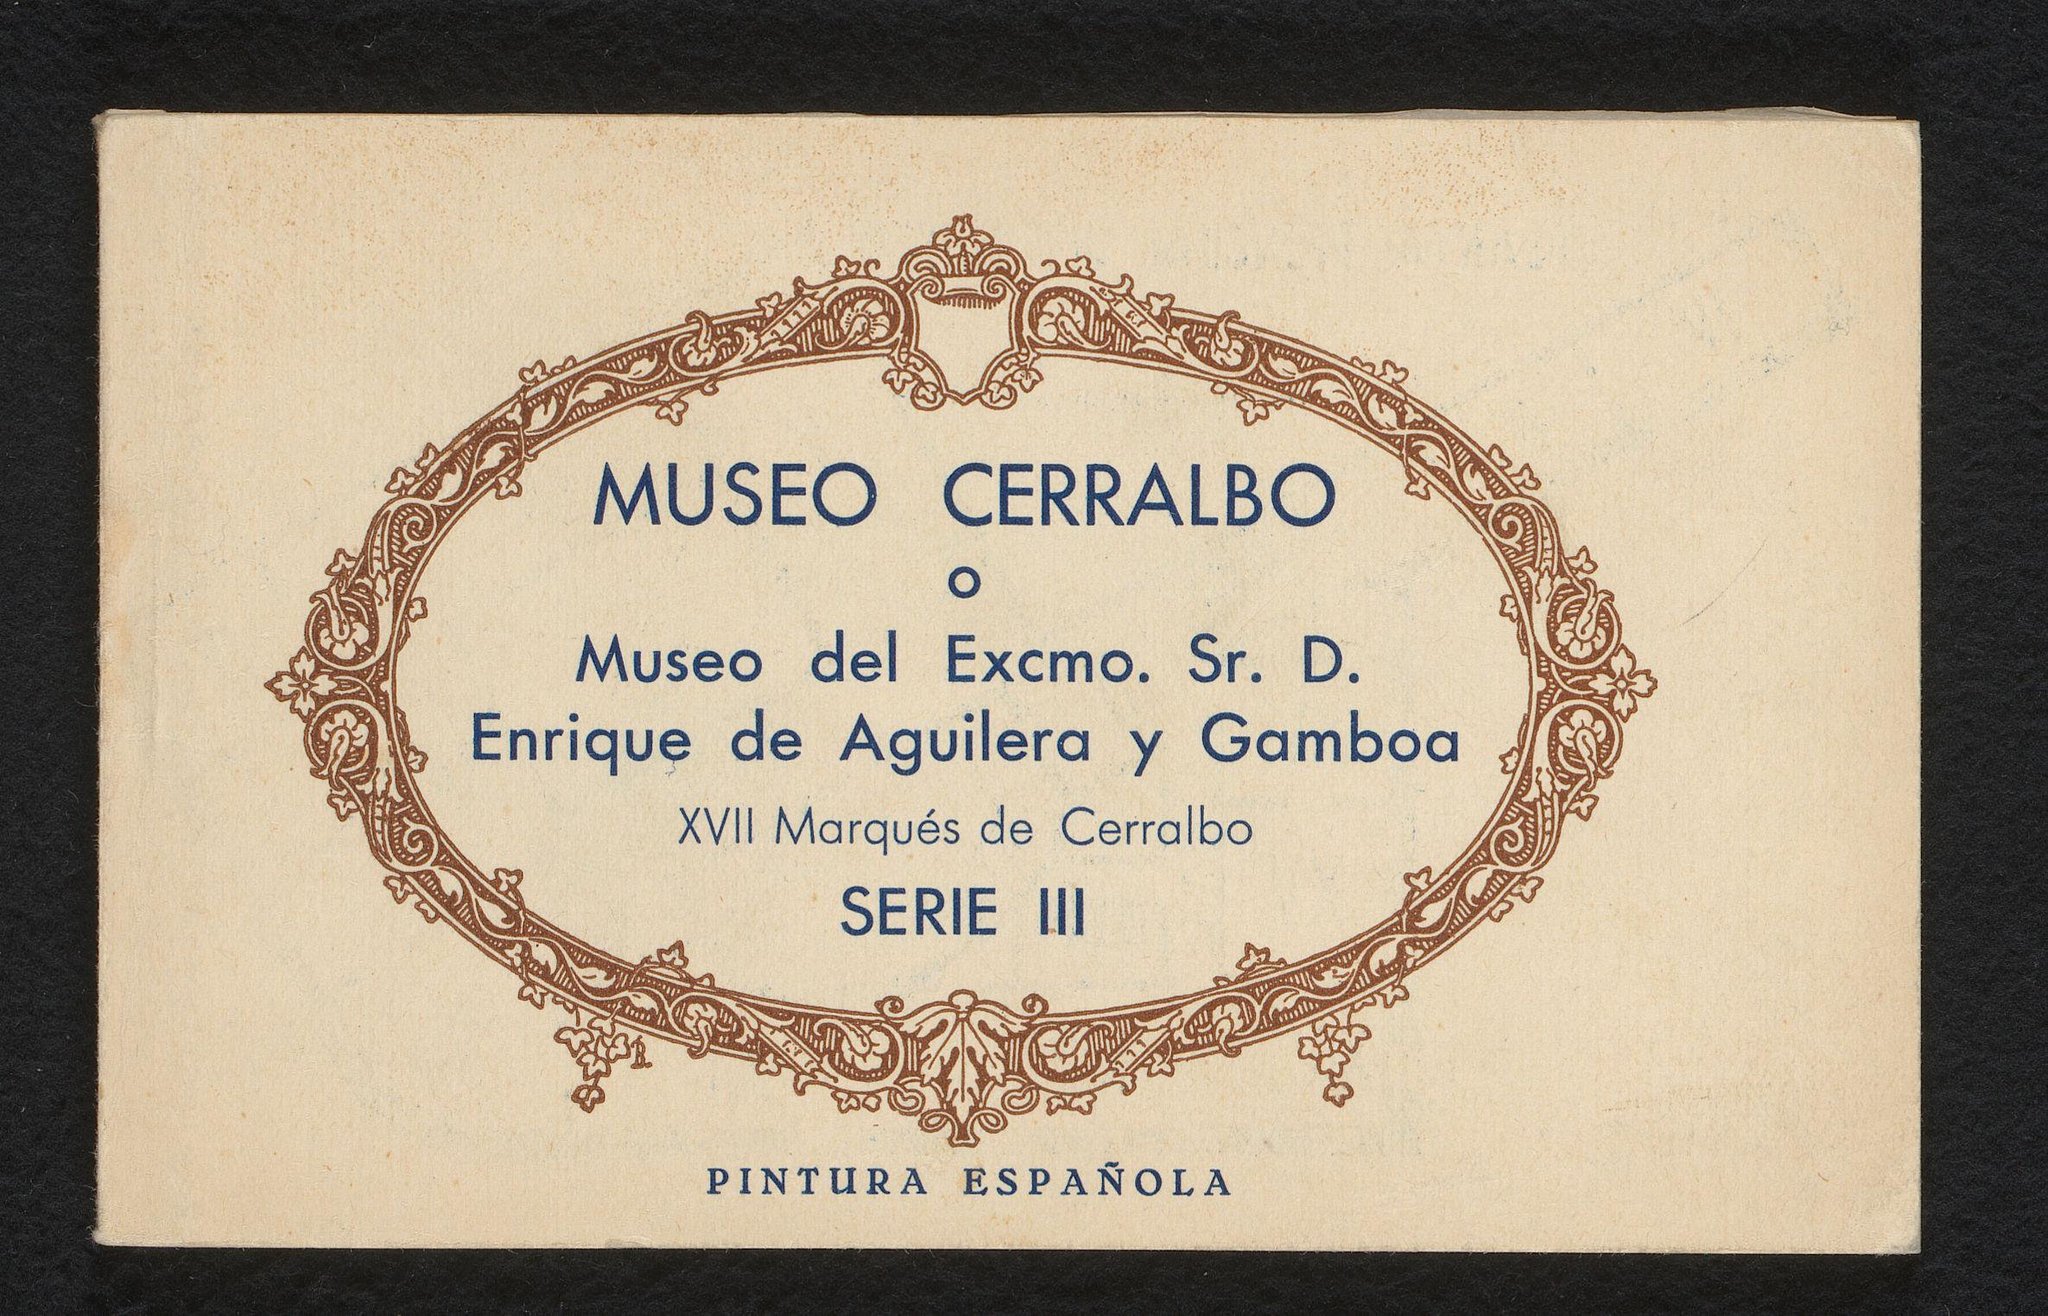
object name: album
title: Museo Cerralbo o Museo del Excmo. Sr. D. Enrique de Aguilera y Gamboa, XVII Marqués de Cerralbo. Serie III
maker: Anonymous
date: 1924-1930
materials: paper, cardboard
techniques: photograph, printing block, stapling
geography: madrid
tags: picture, painting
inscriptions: collector's mark: ‘AFE v S’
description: Album met twintig prentbriefkaarten met kunstreproducties uit het Museo Cerralbo te Madrid. De prentbriefkaarten kunnen eruit gescheurd worden.